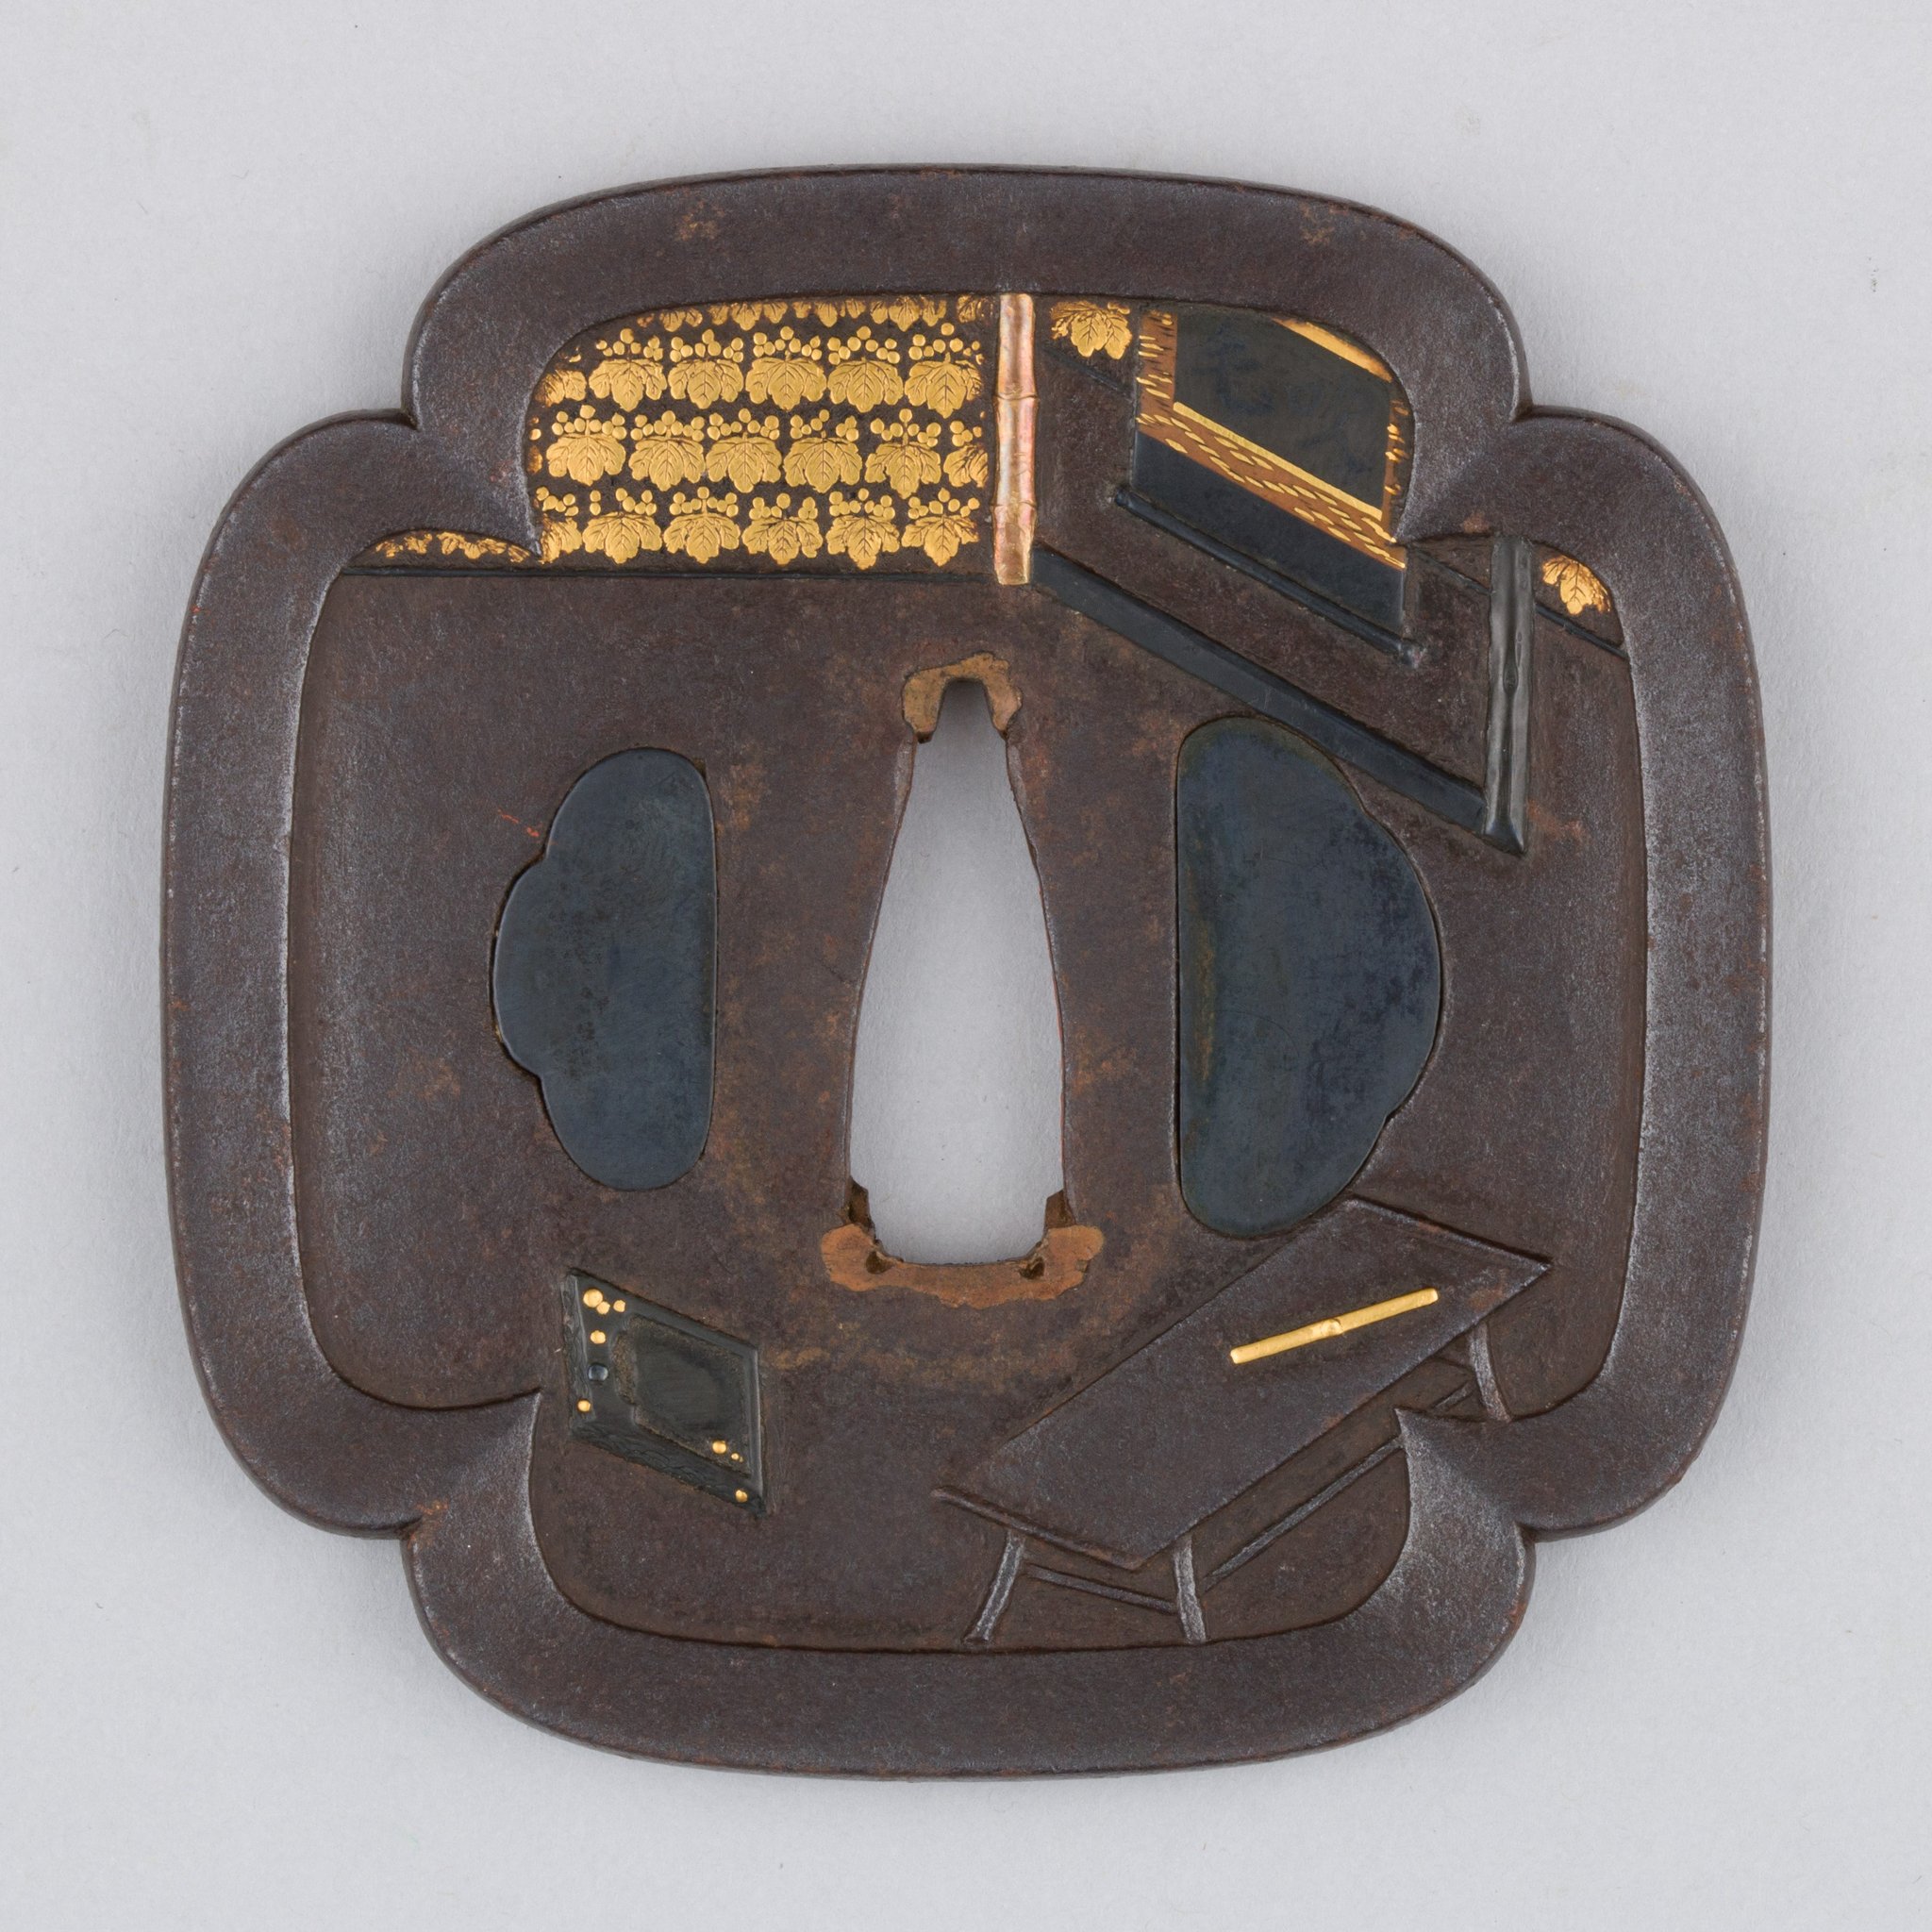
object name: sword guard tsuba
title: Sword Guard (Tsuba)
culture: japanese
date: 1701-1733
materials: bronze, copper, gold alloy, gold, iron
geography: japan